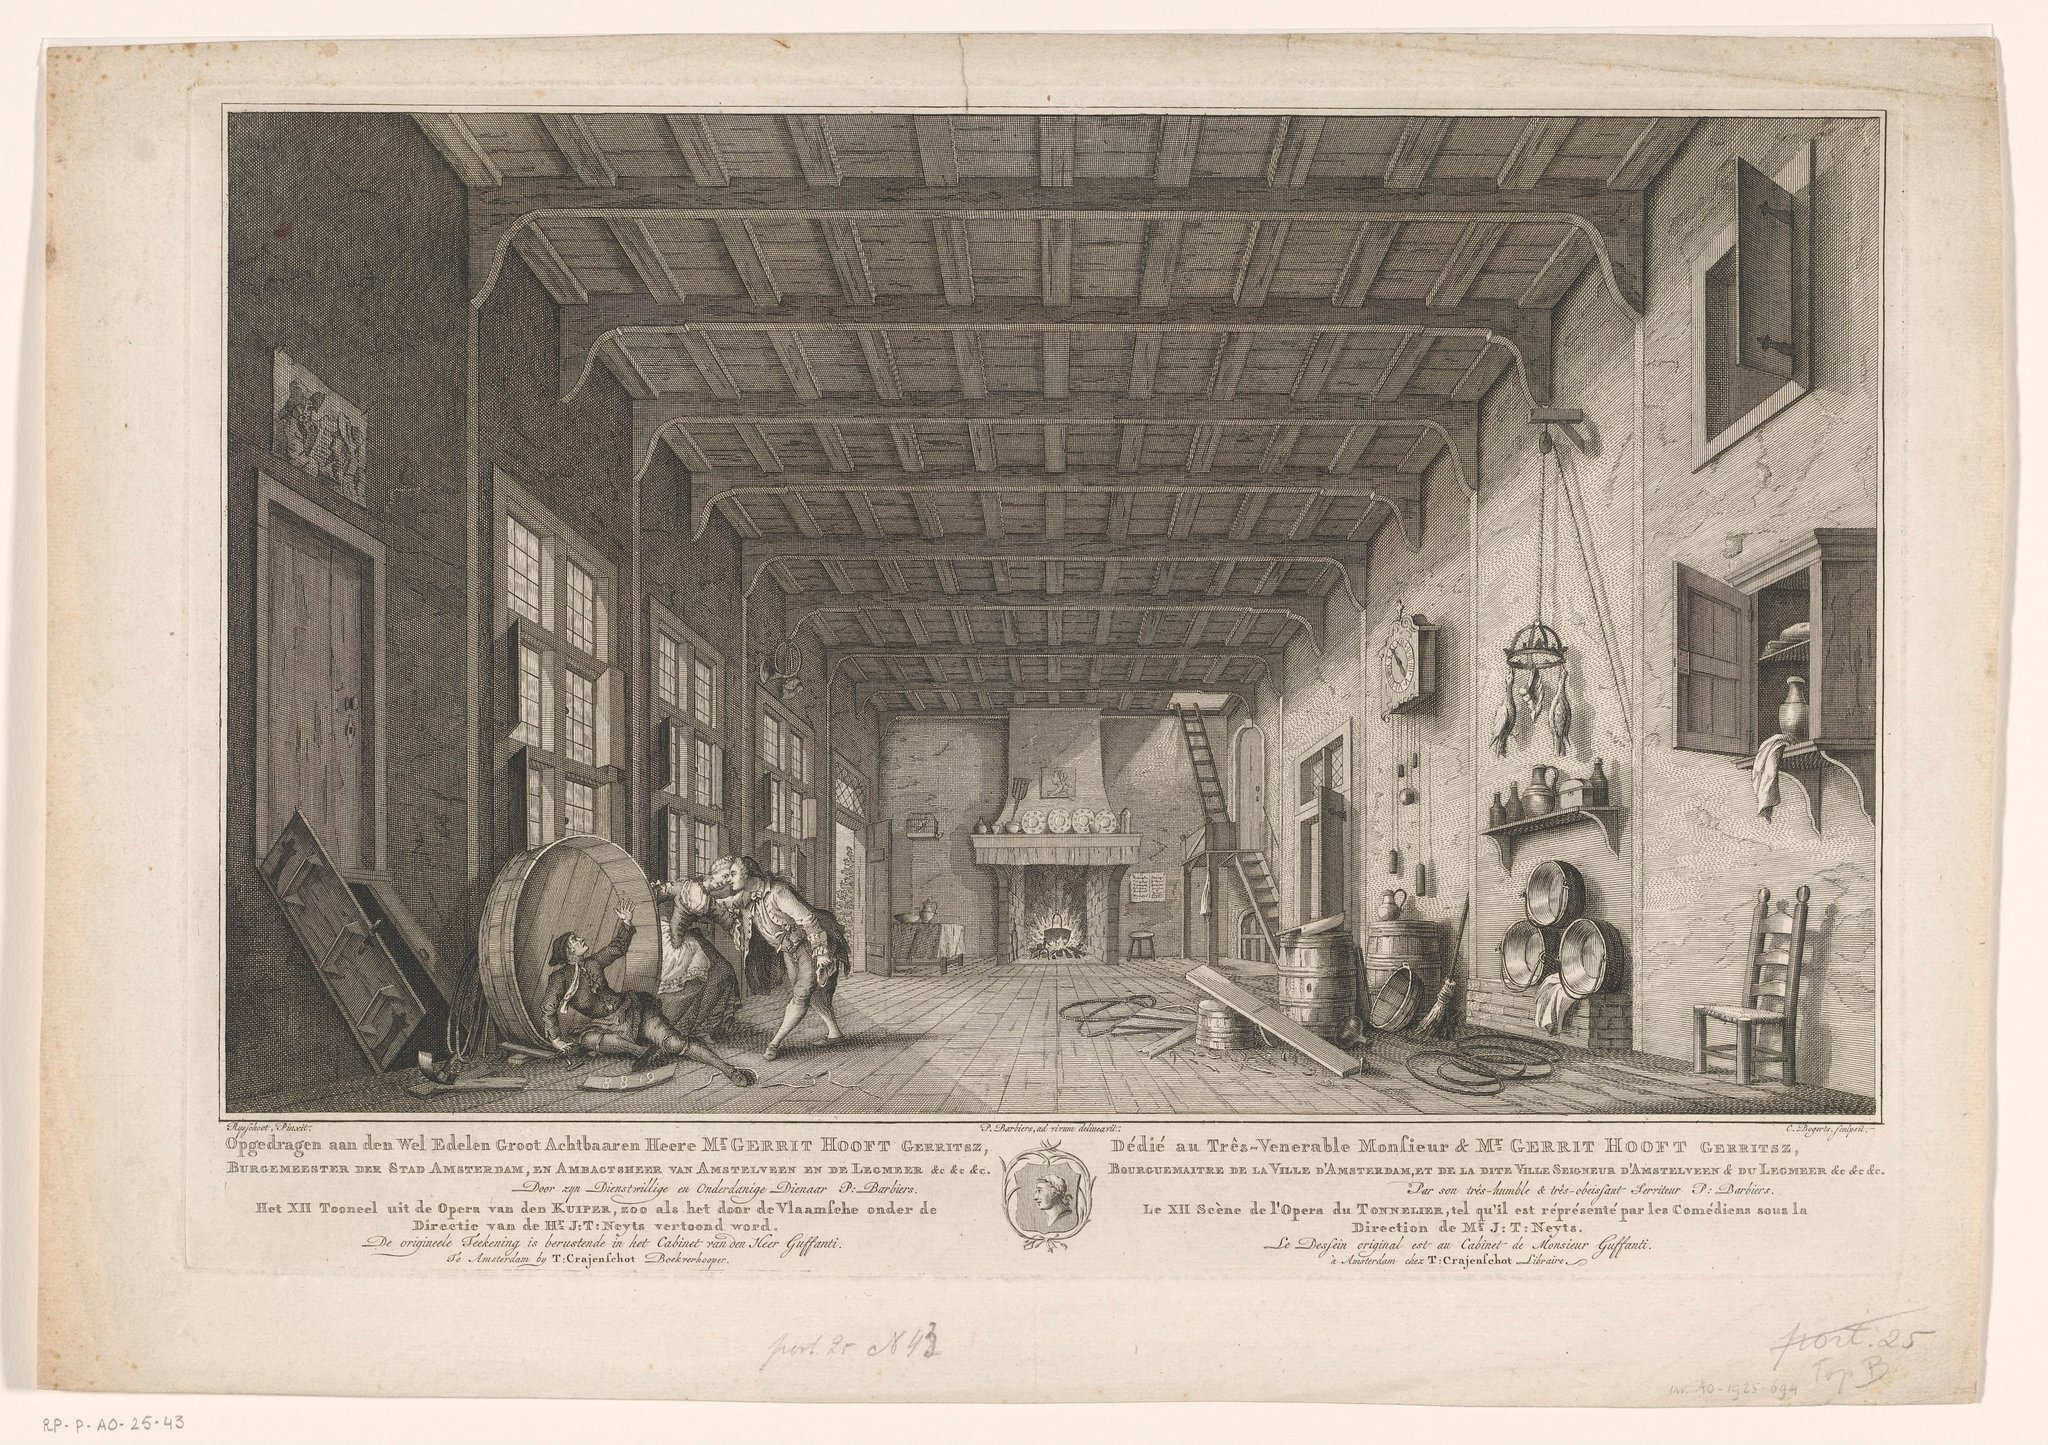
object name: print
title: Scène uit de opera De Kuiper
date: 1768-1772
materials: paper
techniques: engraving, etching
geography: amsterdam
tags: opera, armorial bearing, heraldry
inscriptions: collector's mark: Lugt 2228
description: Opgedragen aan burgemeester Gerrit Gerritsz. Hooft, die in november 1767 overleed. Deze opera, die in 1768 voor het eerst elders in het Frans werd opgevoerd, ging echter pas in 1768 in Amsterdam in première onder de directie van Jacques Toussaint Neyts. De enige andere Gerrit Hooft die burgemeester is geweest was zijn vader, die reeds in 1717 was overleden.